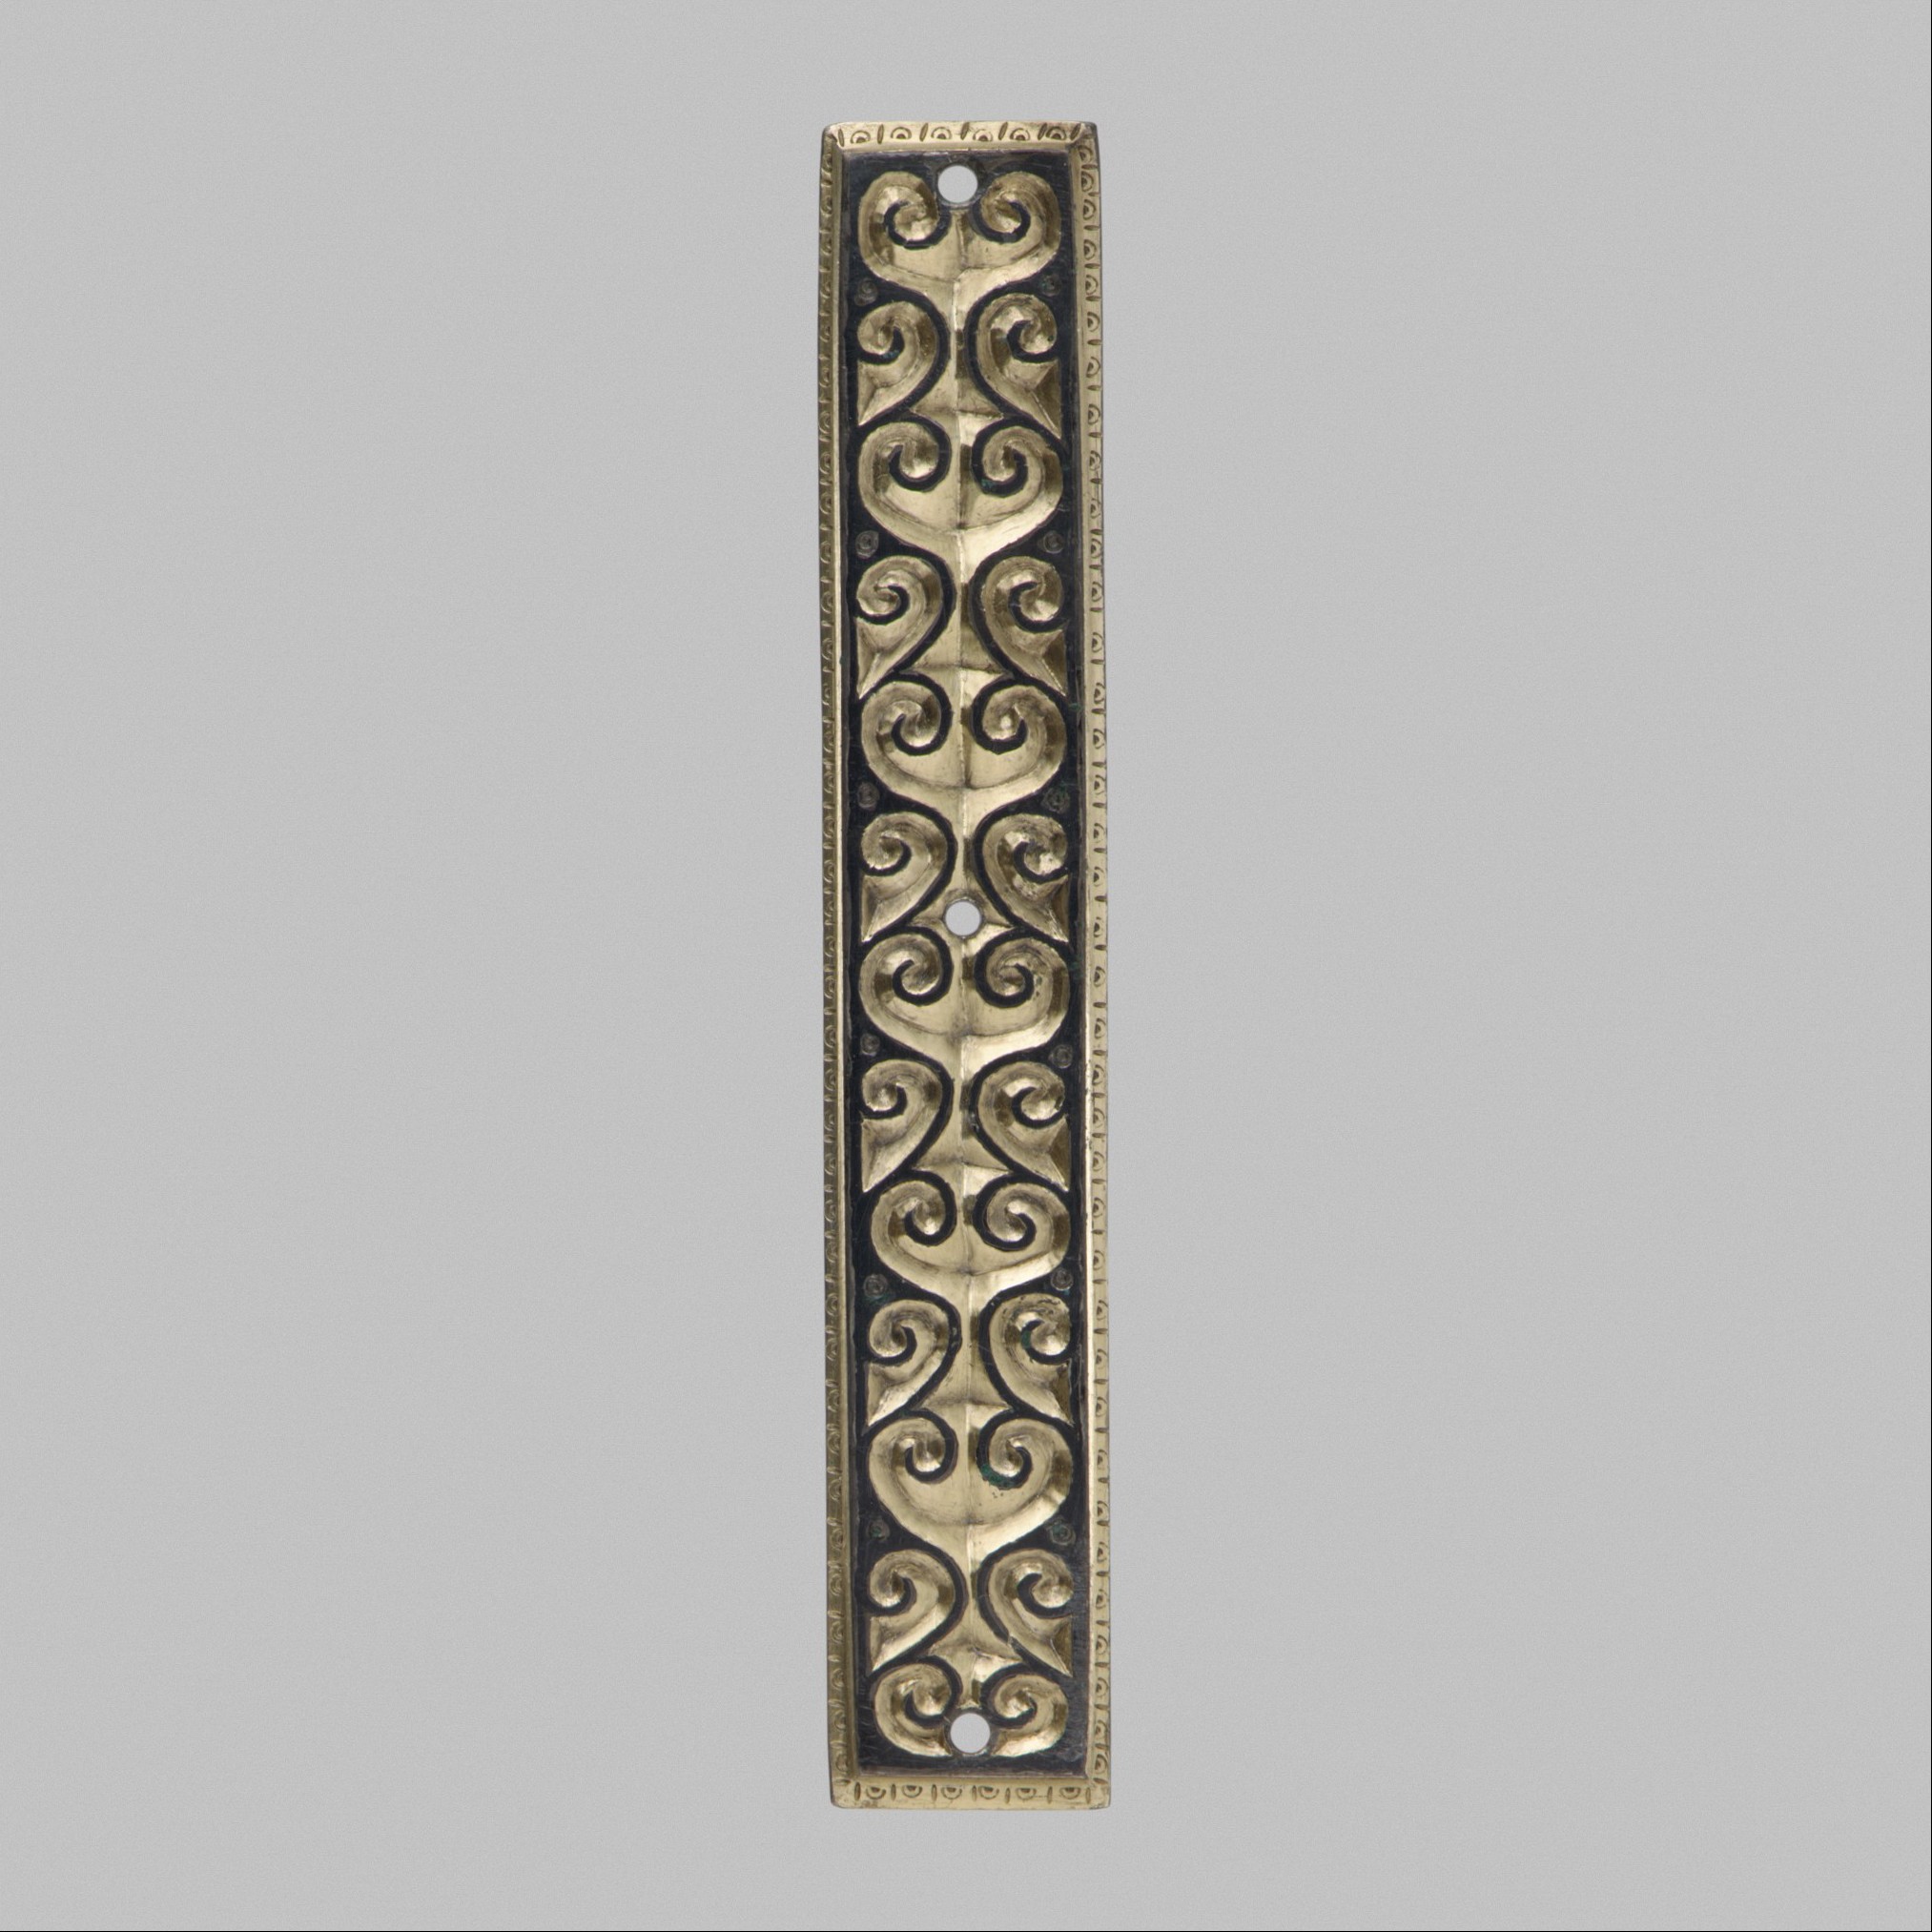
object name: spear shaft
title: Mount for Spear-Shaft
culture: roman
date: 400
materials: niello, silver gilt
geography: france